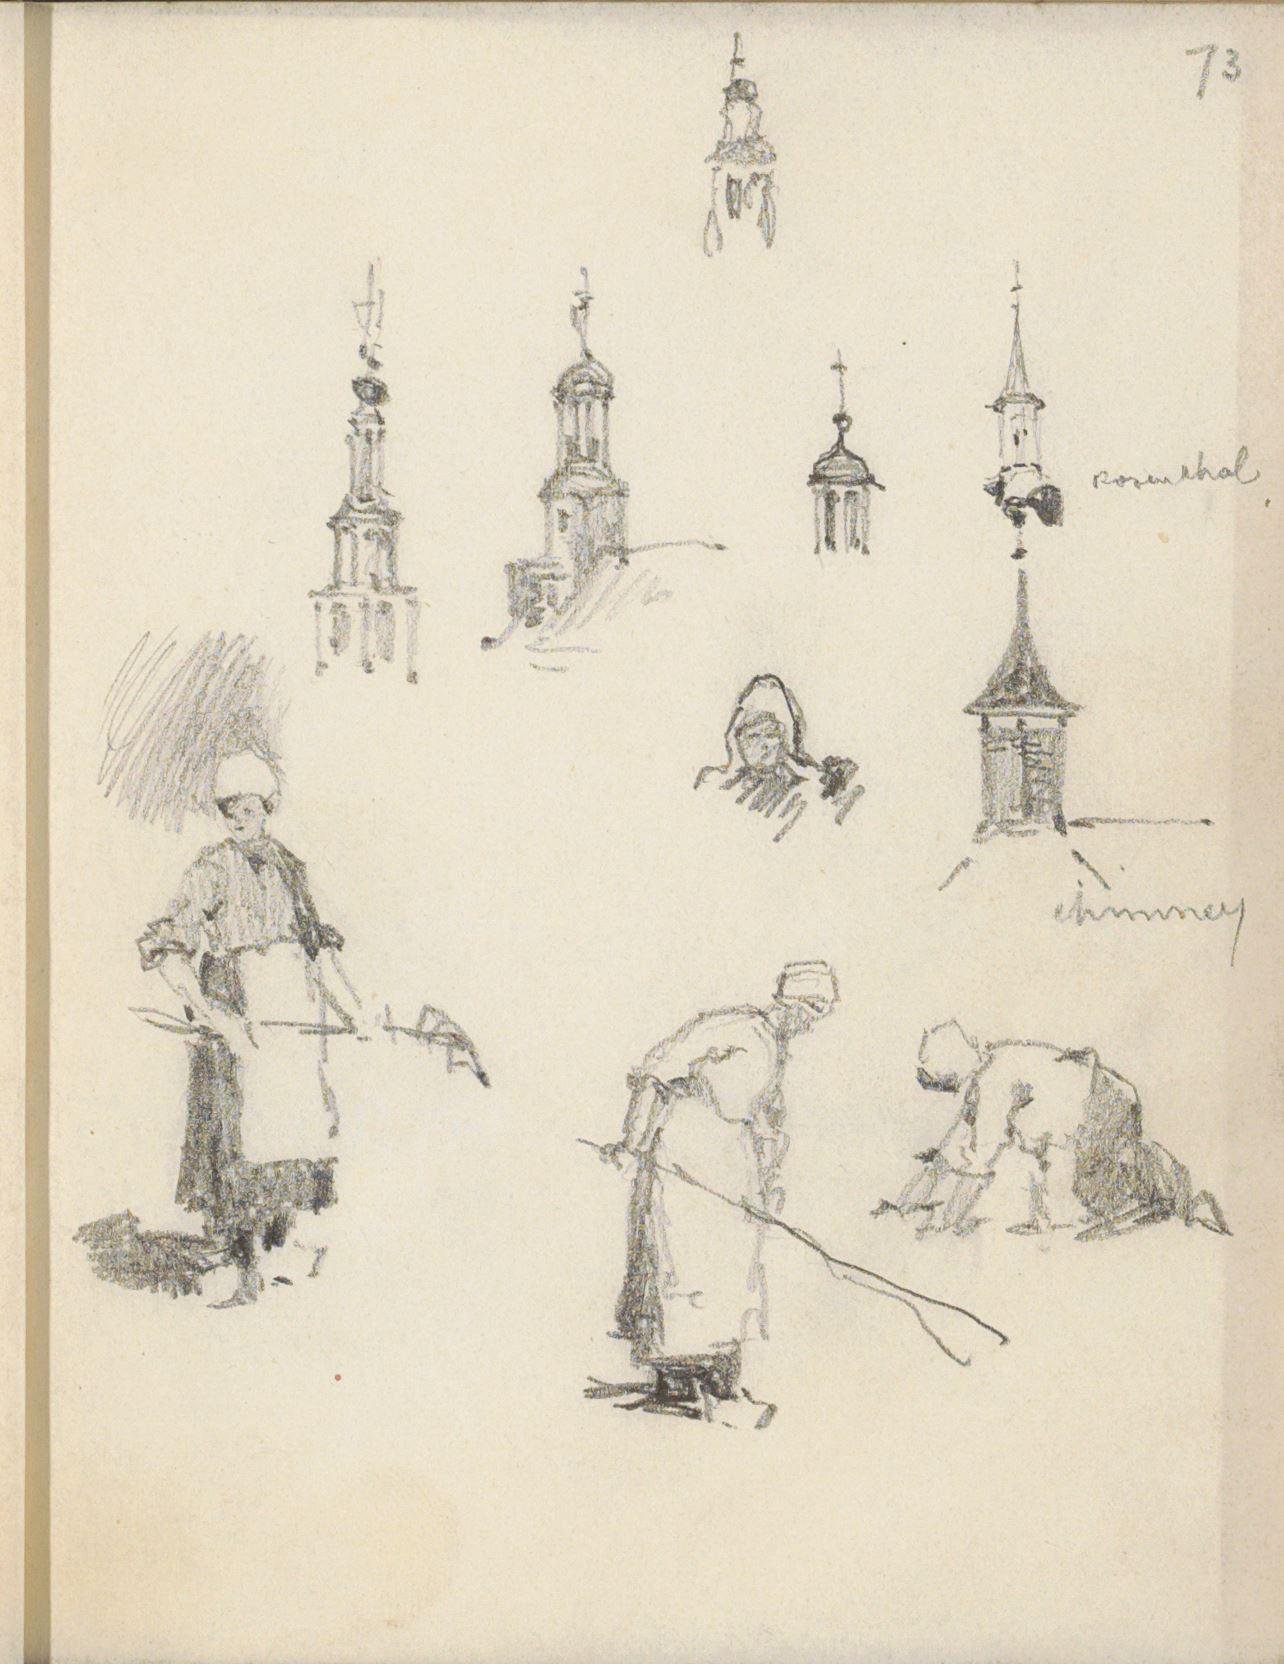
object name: sketchbook leaf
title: Kerktorens, een schoorsteen en landarbeidsters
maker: alfred william rich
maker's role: draughtsman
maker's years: 1856-1921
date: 1892-1893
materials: paper, pencil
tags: chimney, working class, labourers, parts of church exterior and annexes: tower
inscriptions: annotation: ‘Rosenthal/ chimney’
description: Blad 73 recto uit een schetsboek met 86 bladen.